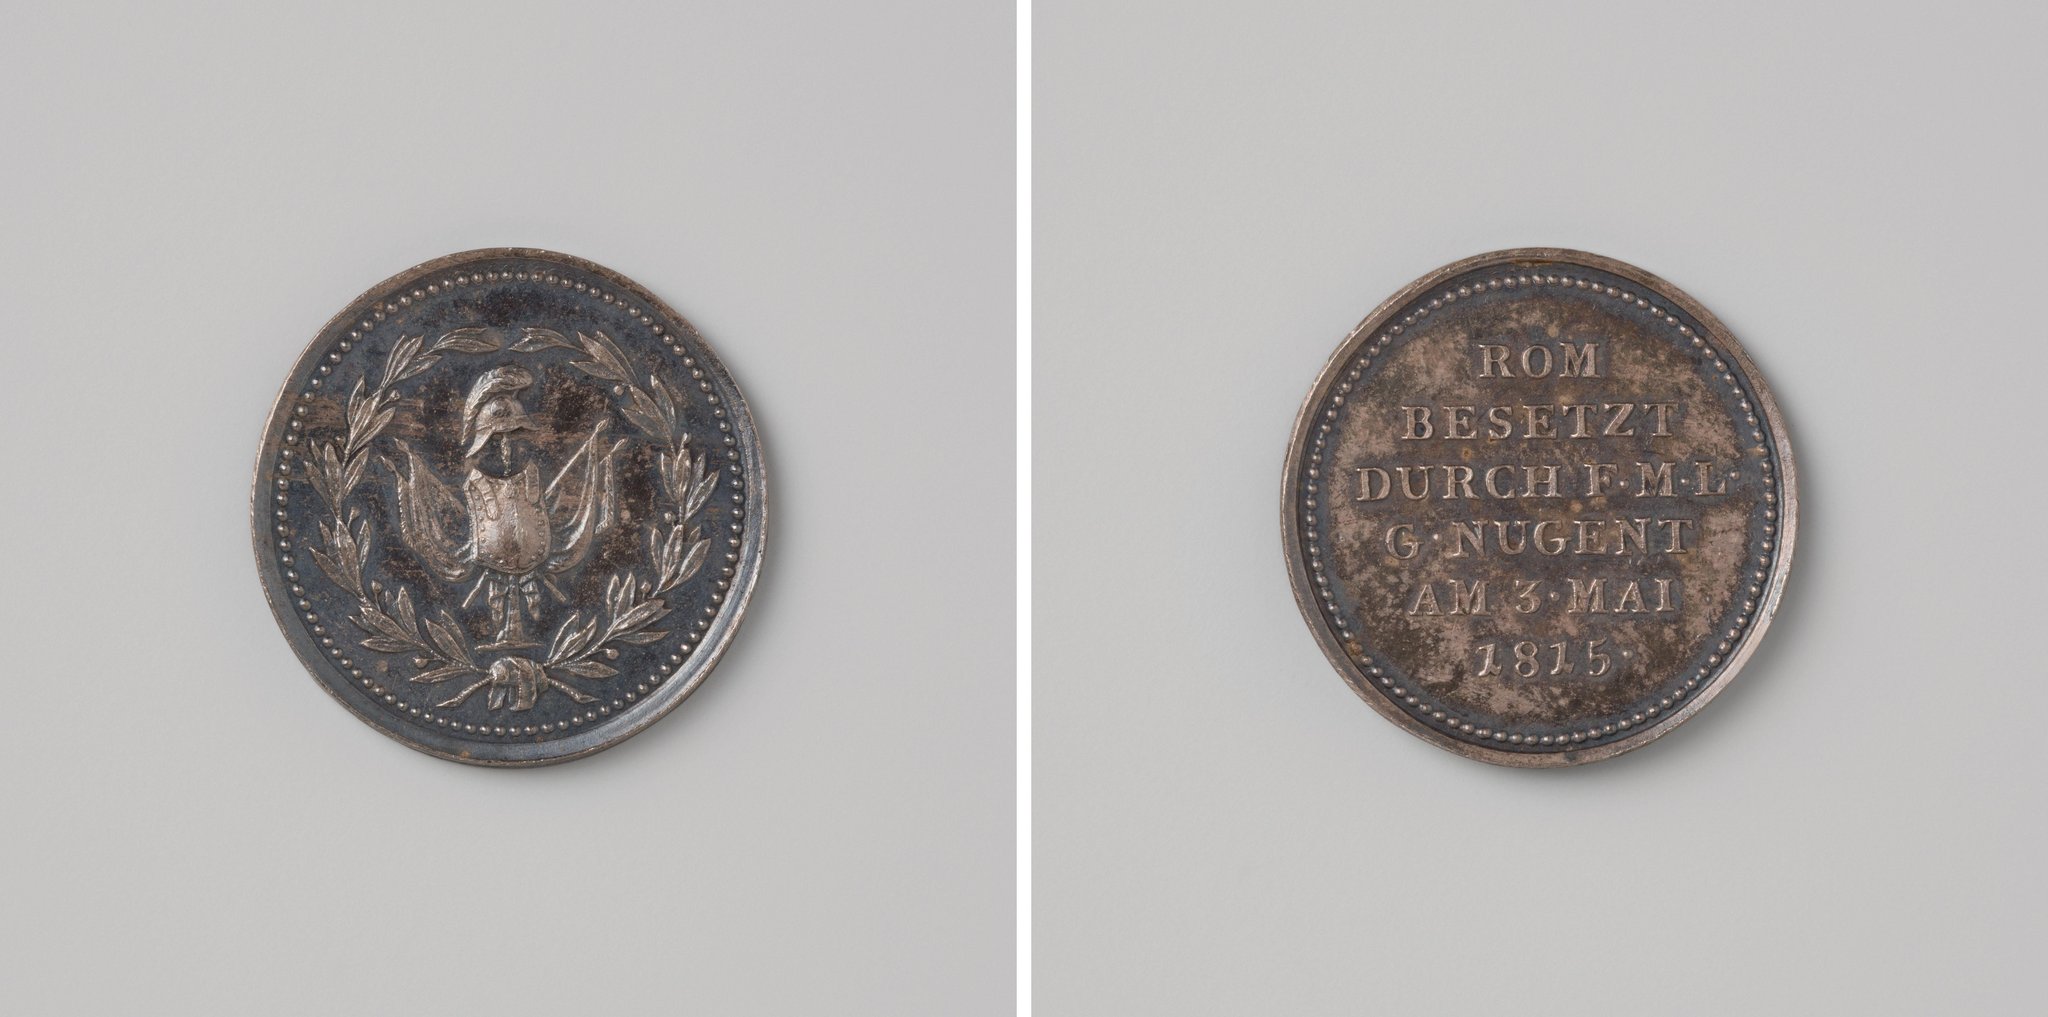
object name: history medal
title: Bezetting van Rome door F.M.L.G. Nugent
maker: Anonymous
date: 1815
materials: silver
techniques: striking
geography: germany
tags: rome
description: Zilveren penning. Voorzijde: zegeteken binnen lauwerkrans. Keerzijde: opschrift